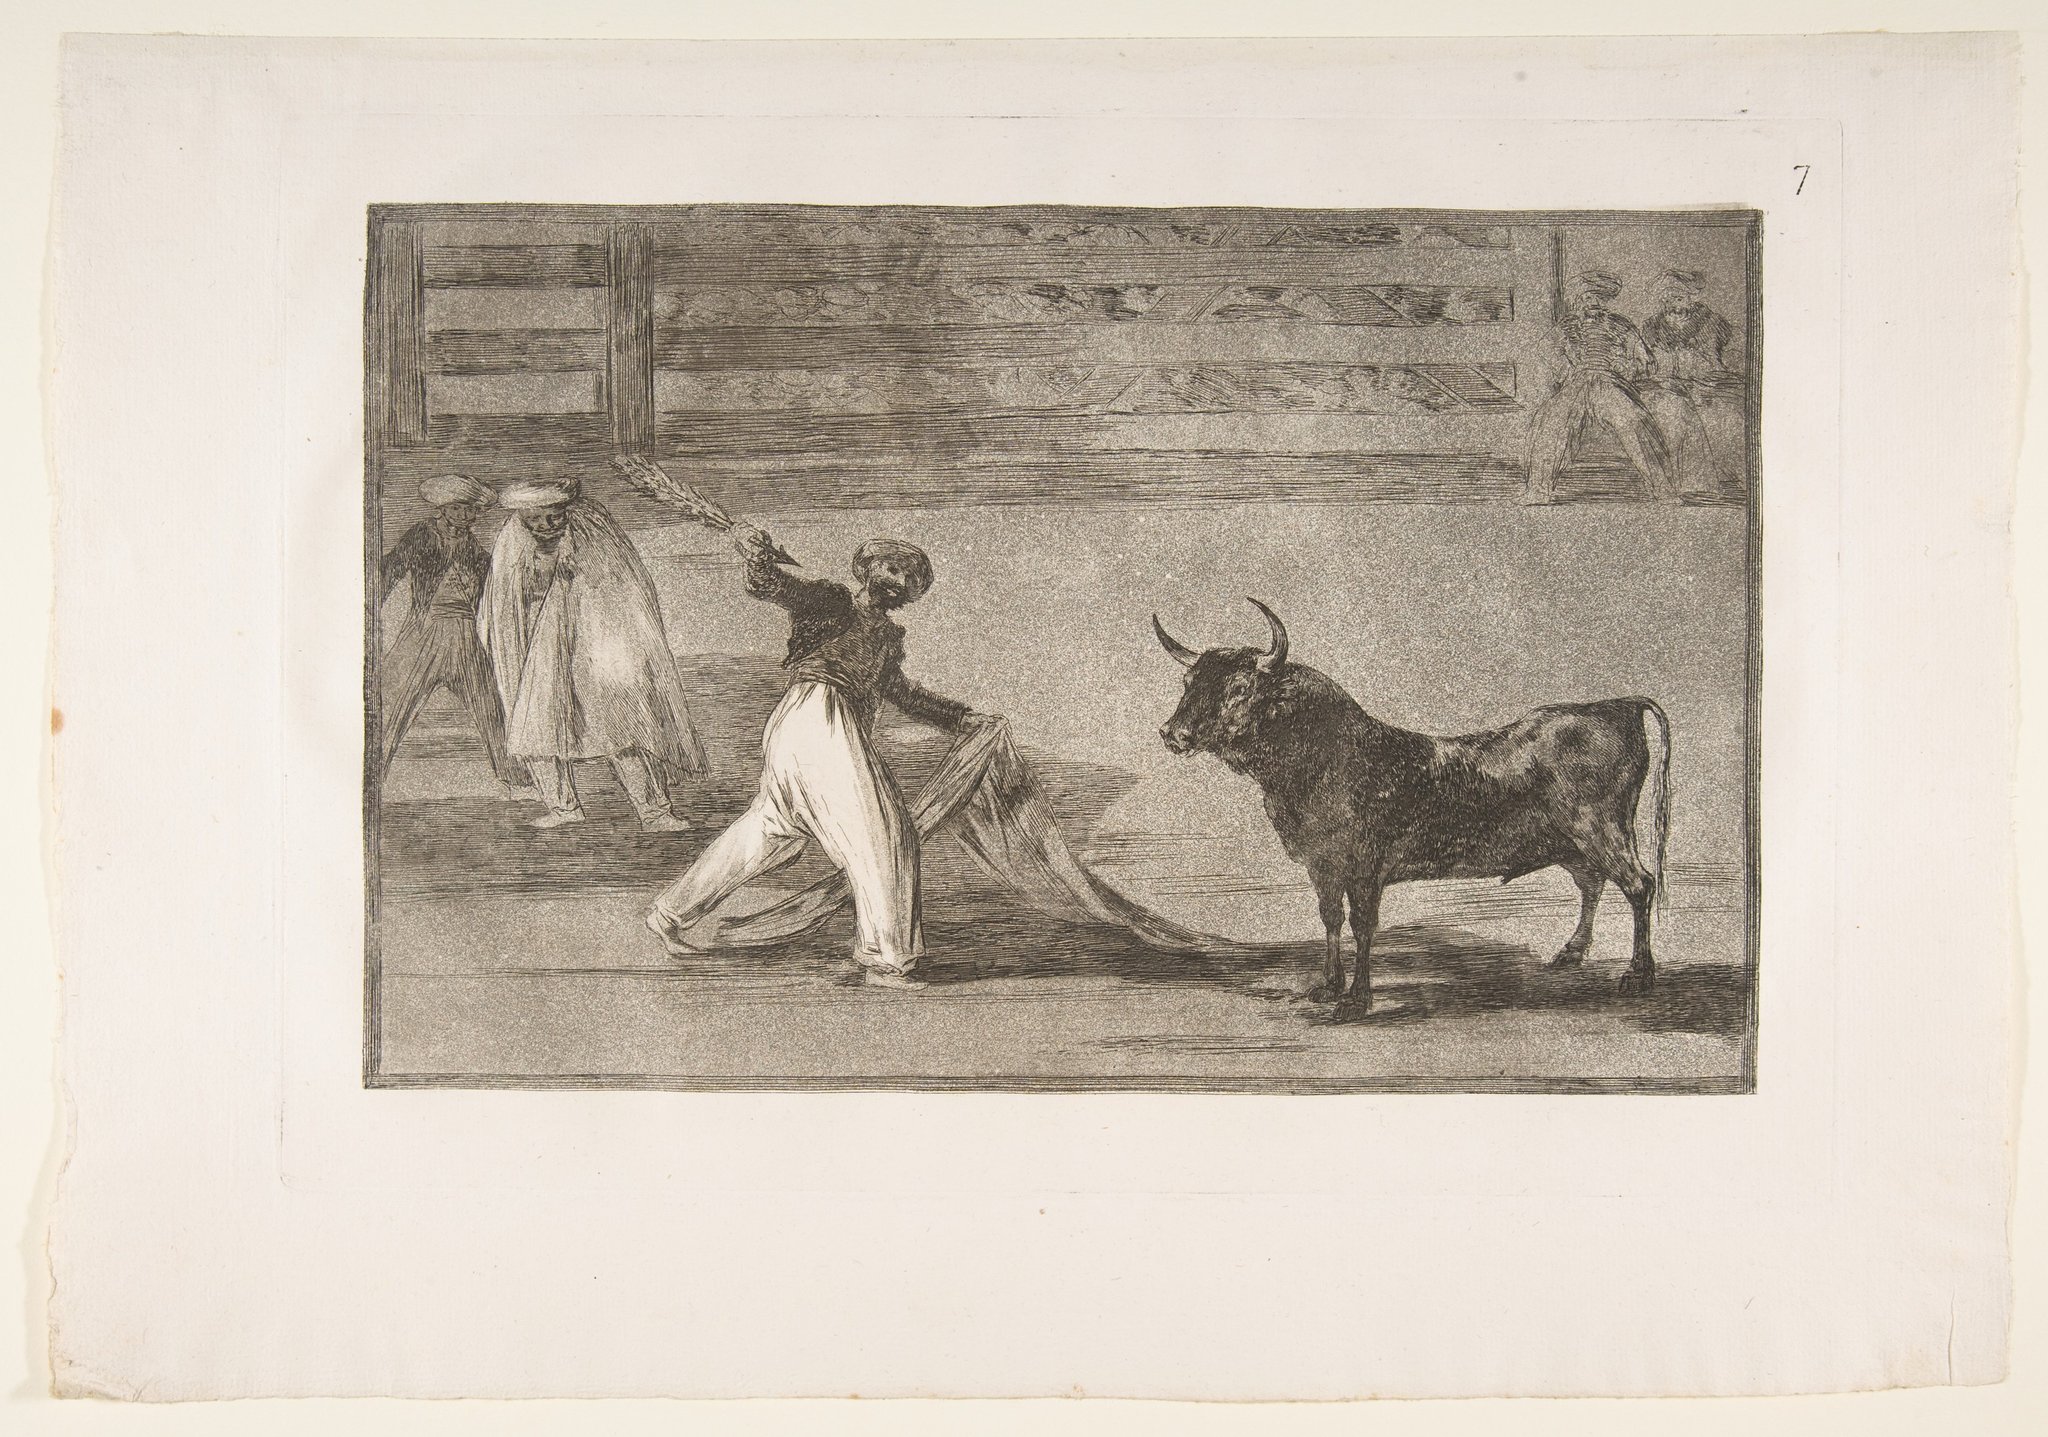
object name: print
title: Plate 7 from "La Tauromaquia": Origin of the harpoon or banderillas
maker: goya (francisco de goya y lucientes)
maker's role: artist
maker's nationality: spanish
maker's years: 1746-1828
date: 1816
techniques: aquatint, engraving, burnishing, etching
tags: men,bulls